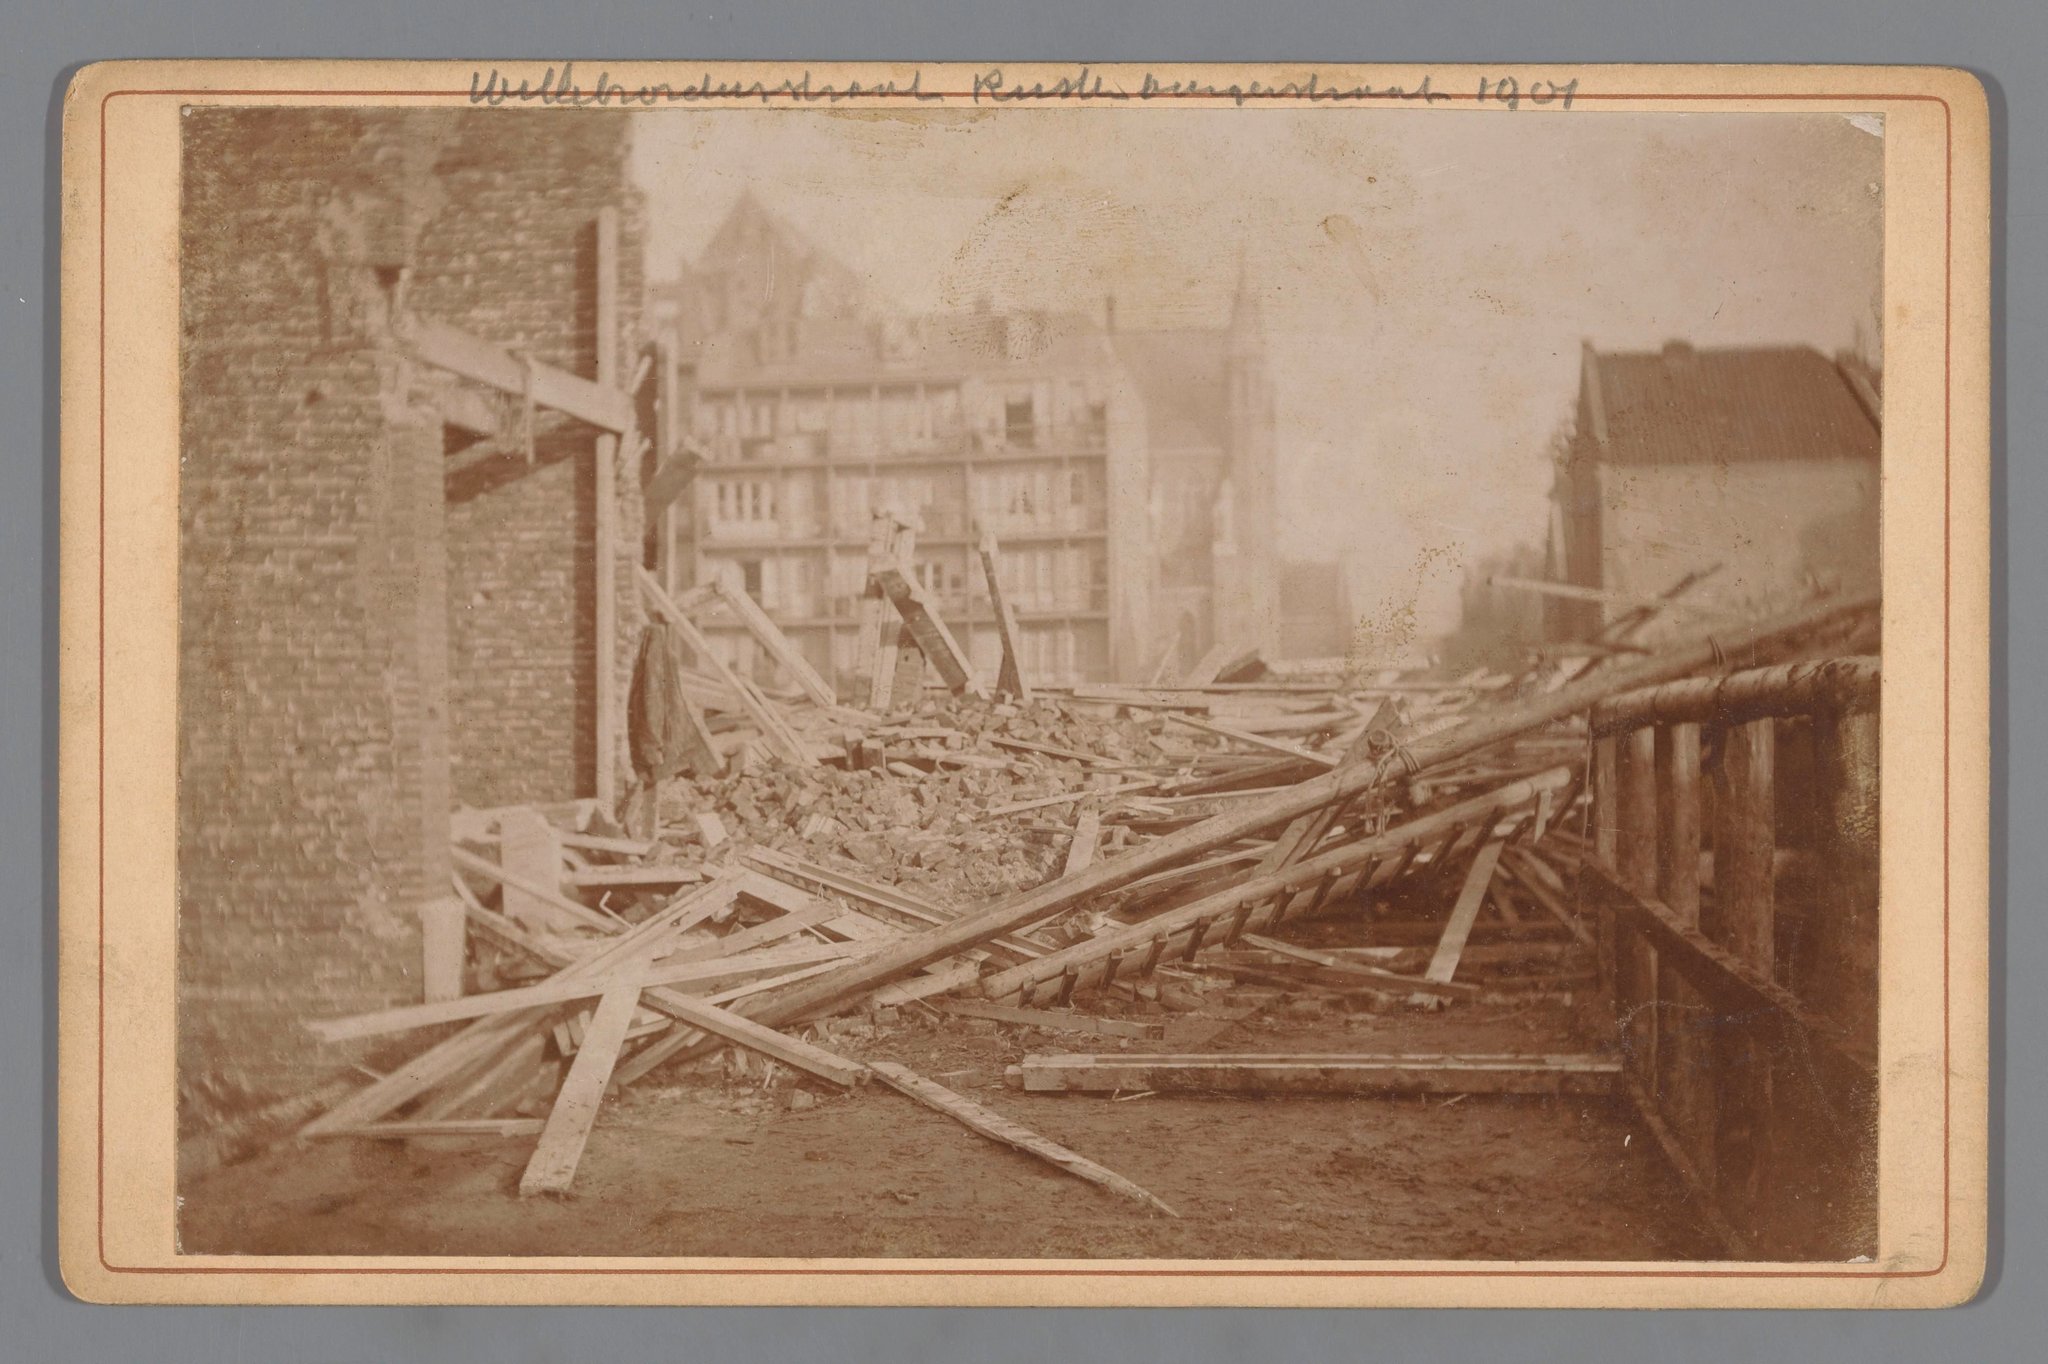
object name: photograph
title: Ingestort gebouw aan de Sint Willibrordusstraat of aan de Rustenburgerstraat in Amsterdam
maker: Anonymous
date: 1901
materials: cardboard, photographic support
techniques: collodion silver print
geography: amsterdam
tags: ruin of a building ~ architecture, amsterdam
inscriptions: annotation: ‘Willibrordusstraat Rustenburgerstraat 1901’